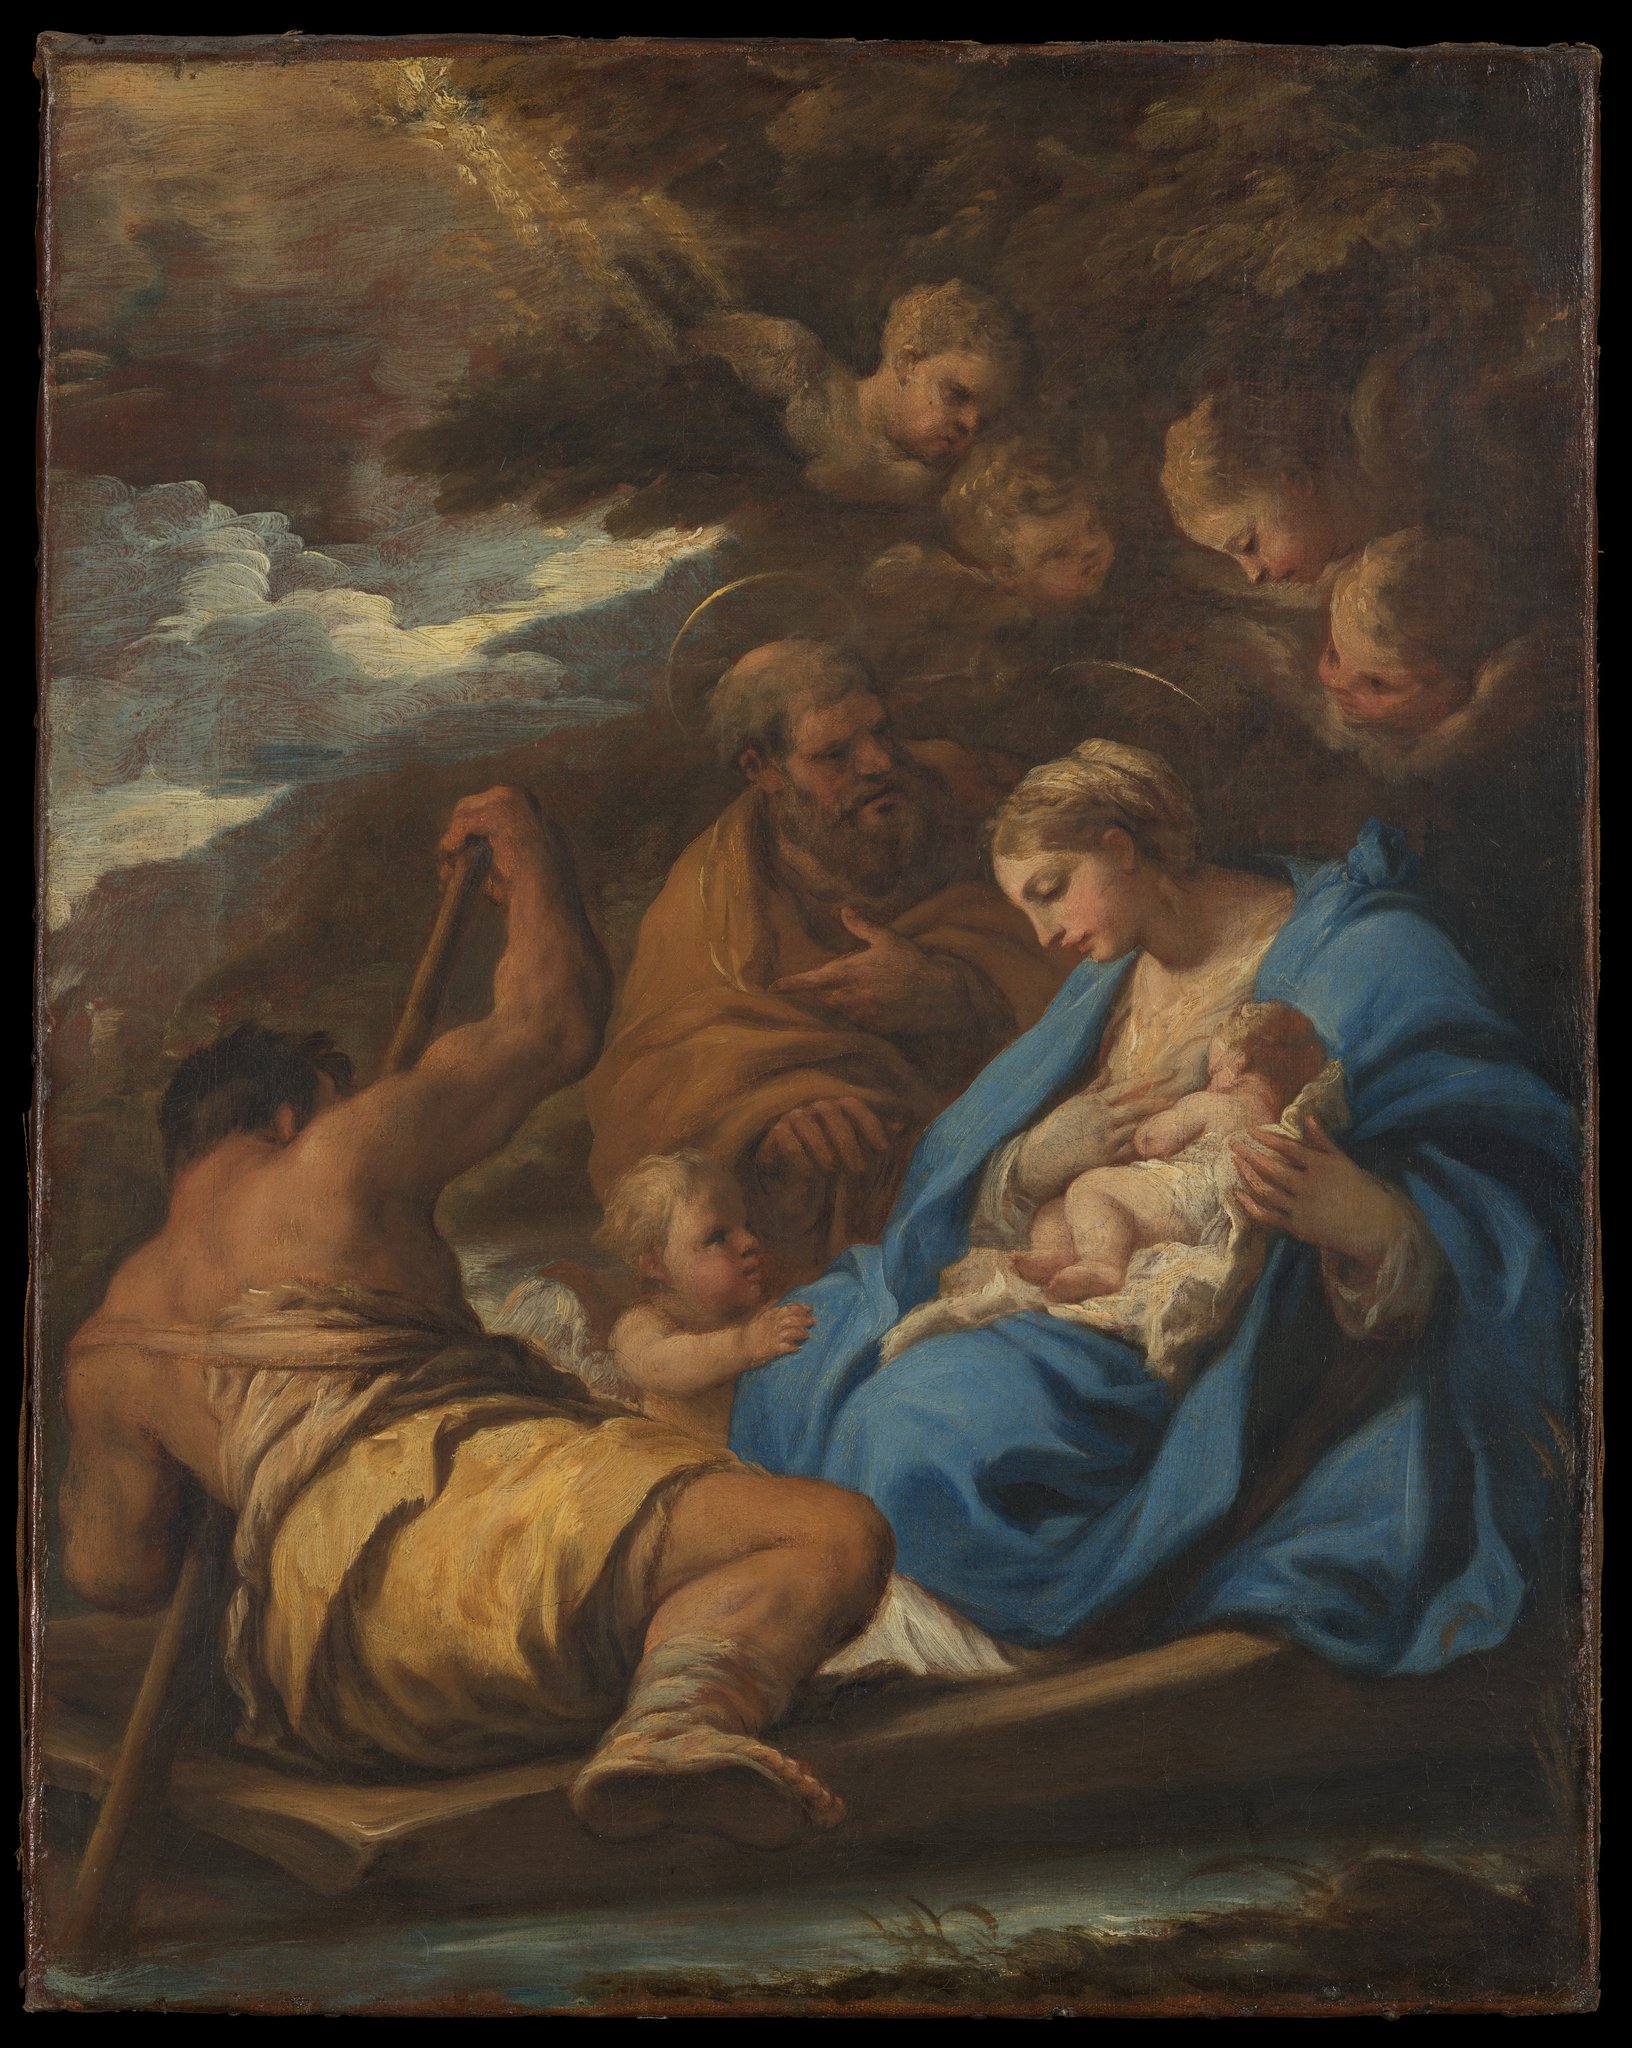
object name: painting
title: The Flight into Egypt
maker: luca giordano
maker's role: artist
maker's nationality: italian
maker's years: 1634-1705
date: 1701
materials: canvas, oil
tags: angels,christ,holy family,saint joseph,virgin mary,boats